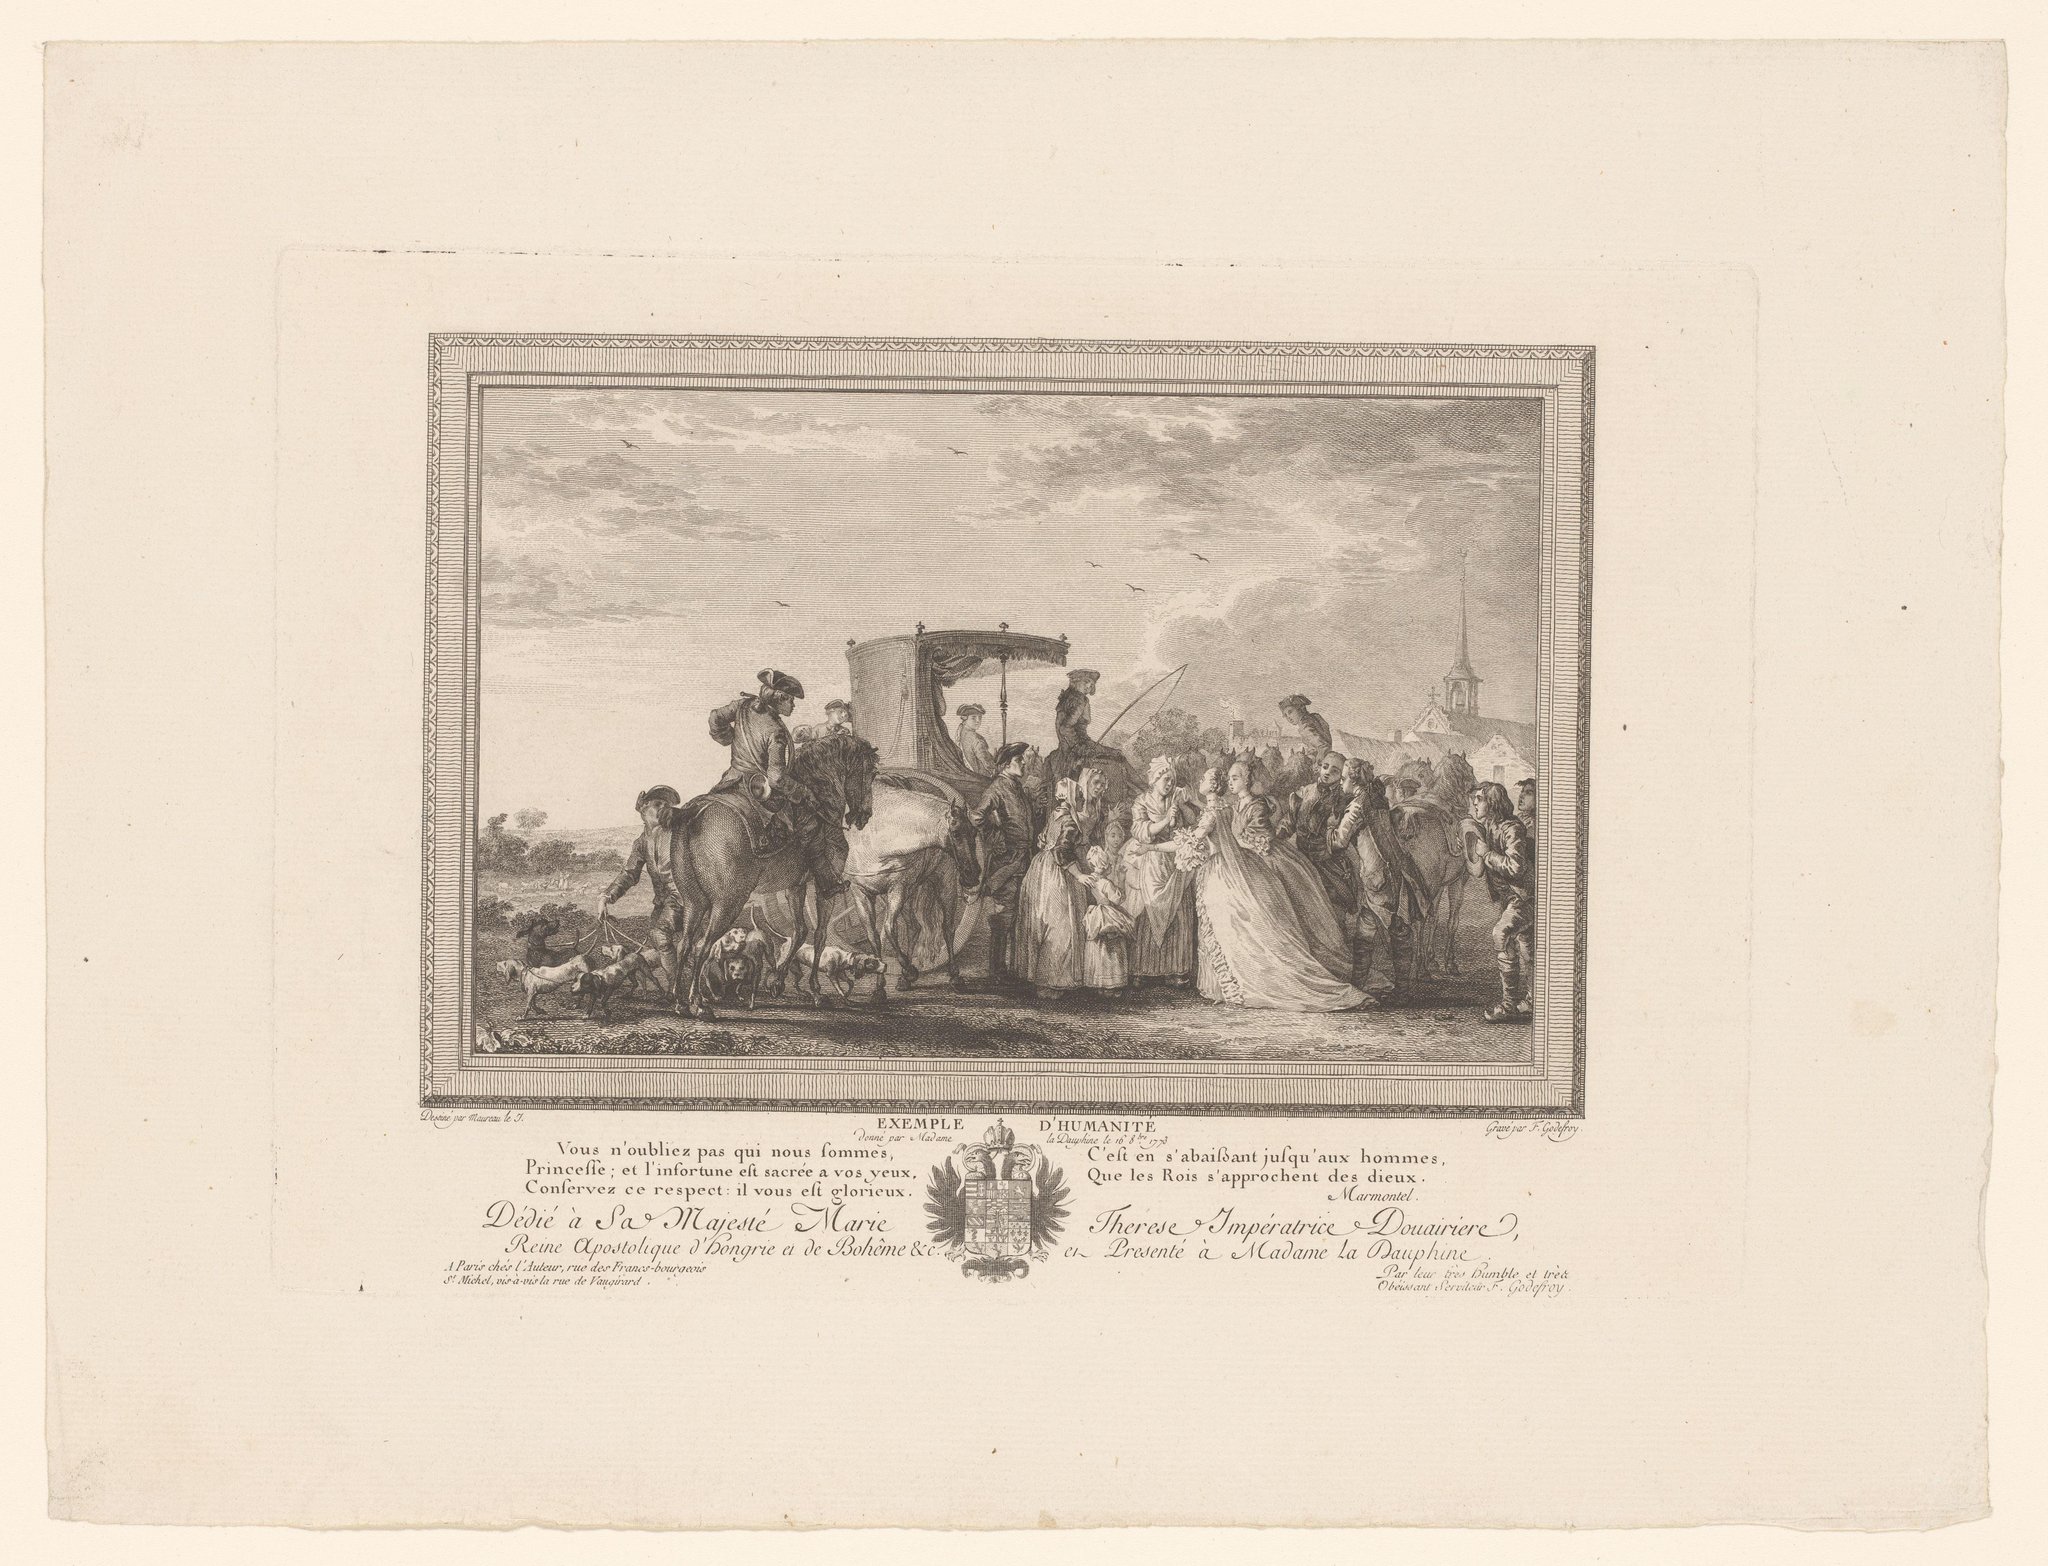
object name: print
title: Exemple d'humanité donné par Madame la Dauphine le 16 Octobre 1773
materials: paper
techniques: etching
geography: france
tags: marie antoinette, historical persons, queen, charitable works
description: Volgens de literatuur pendant van een prent getiteld: 'Retour de chasse' door Duclos.